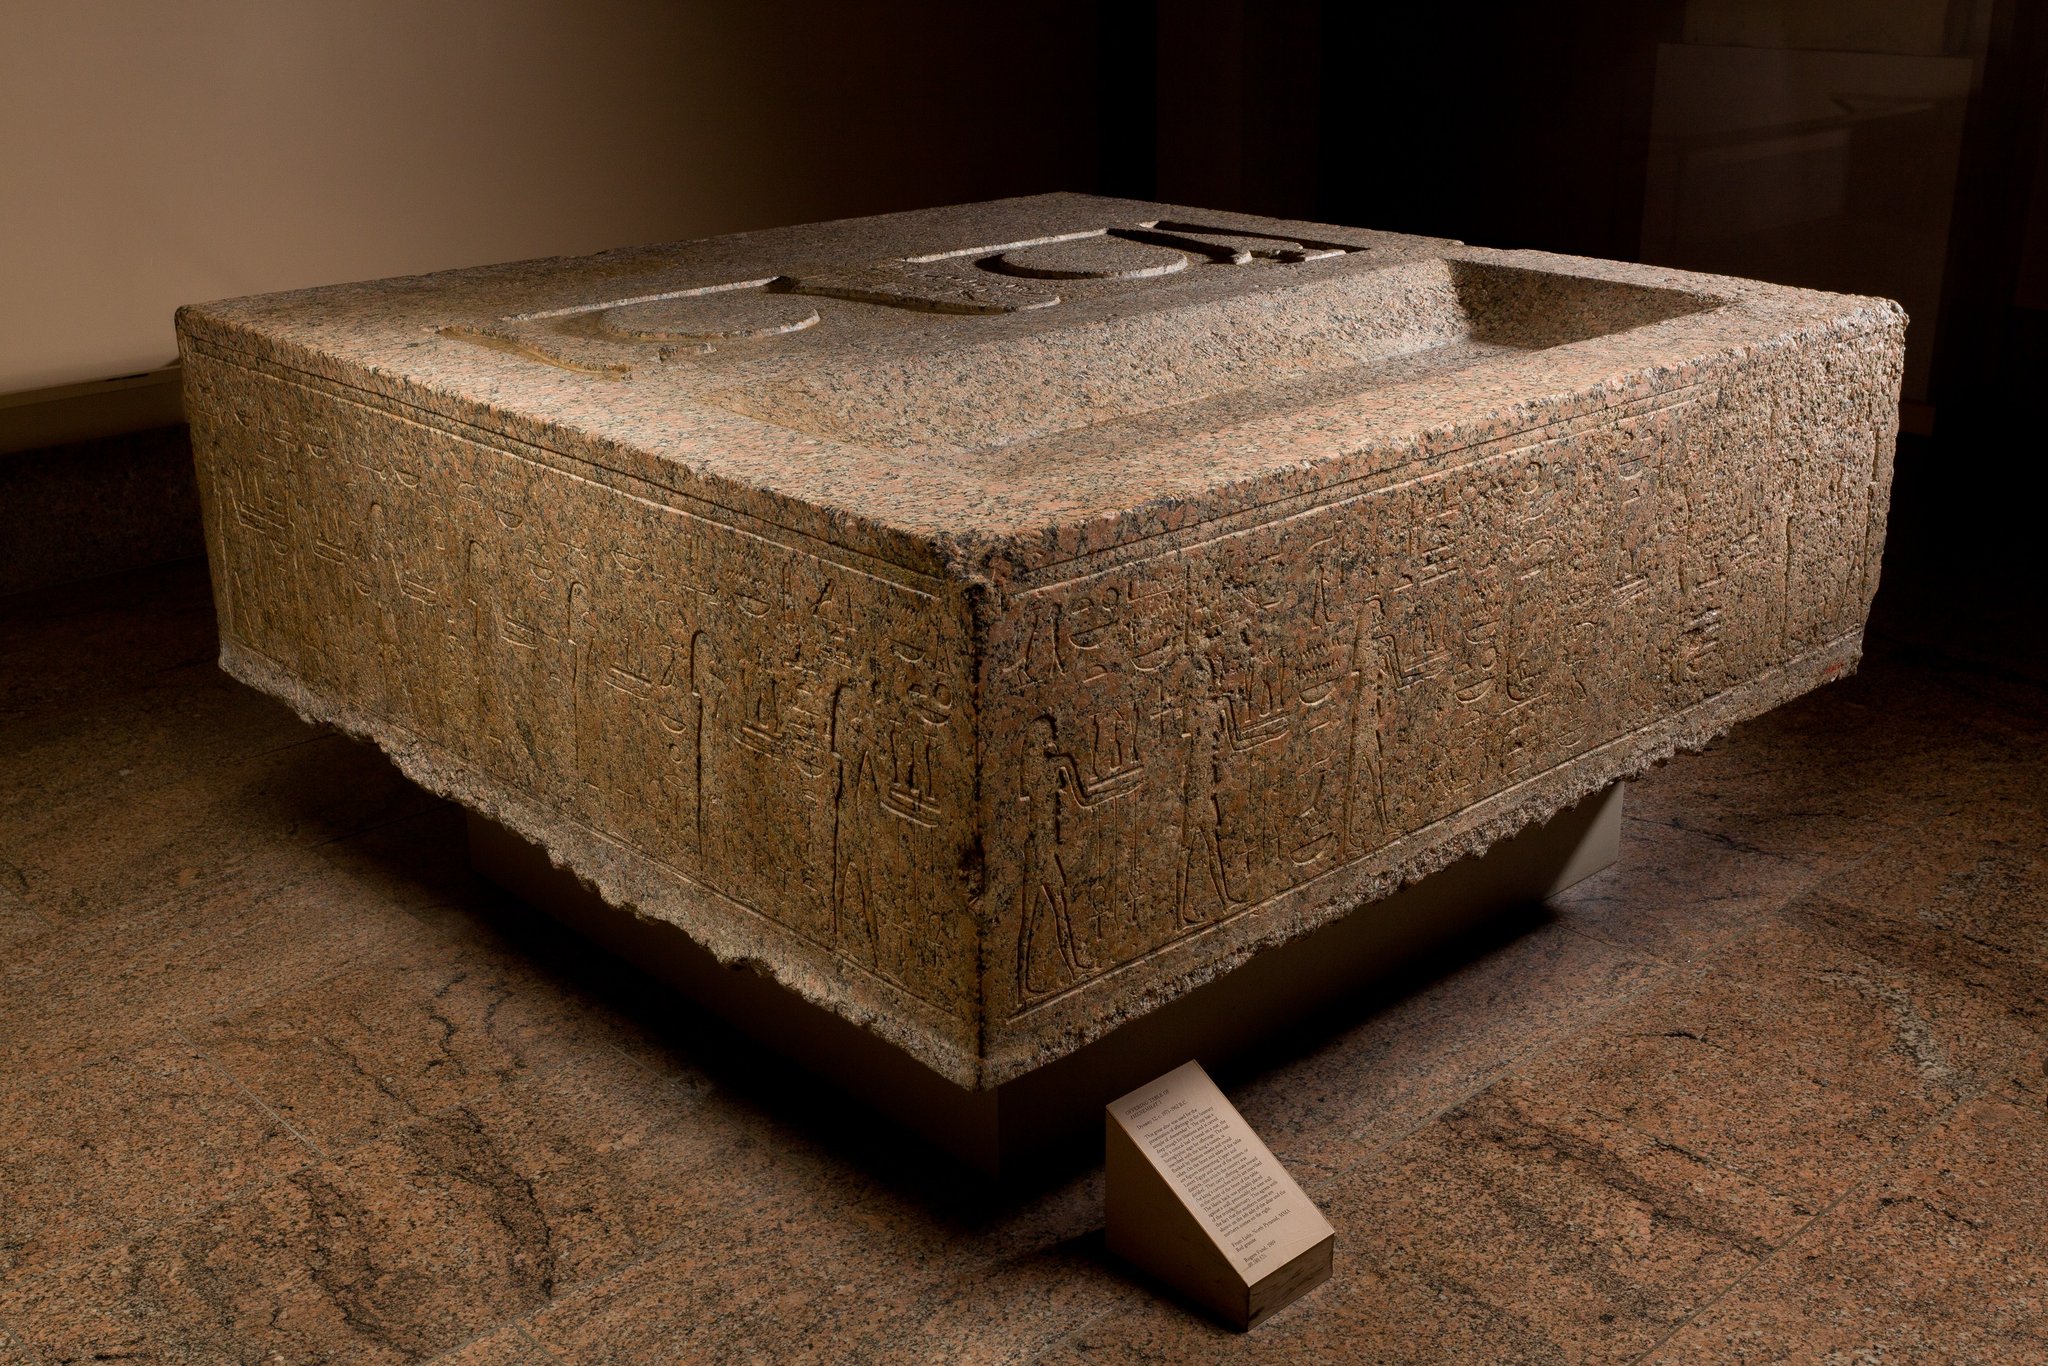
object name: offering table, amenemhat i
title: Offering table from the mortuary temple of Amenemhat I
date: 1981-1952 BCE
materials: granite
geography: egypt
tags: altars,hieroglyphs